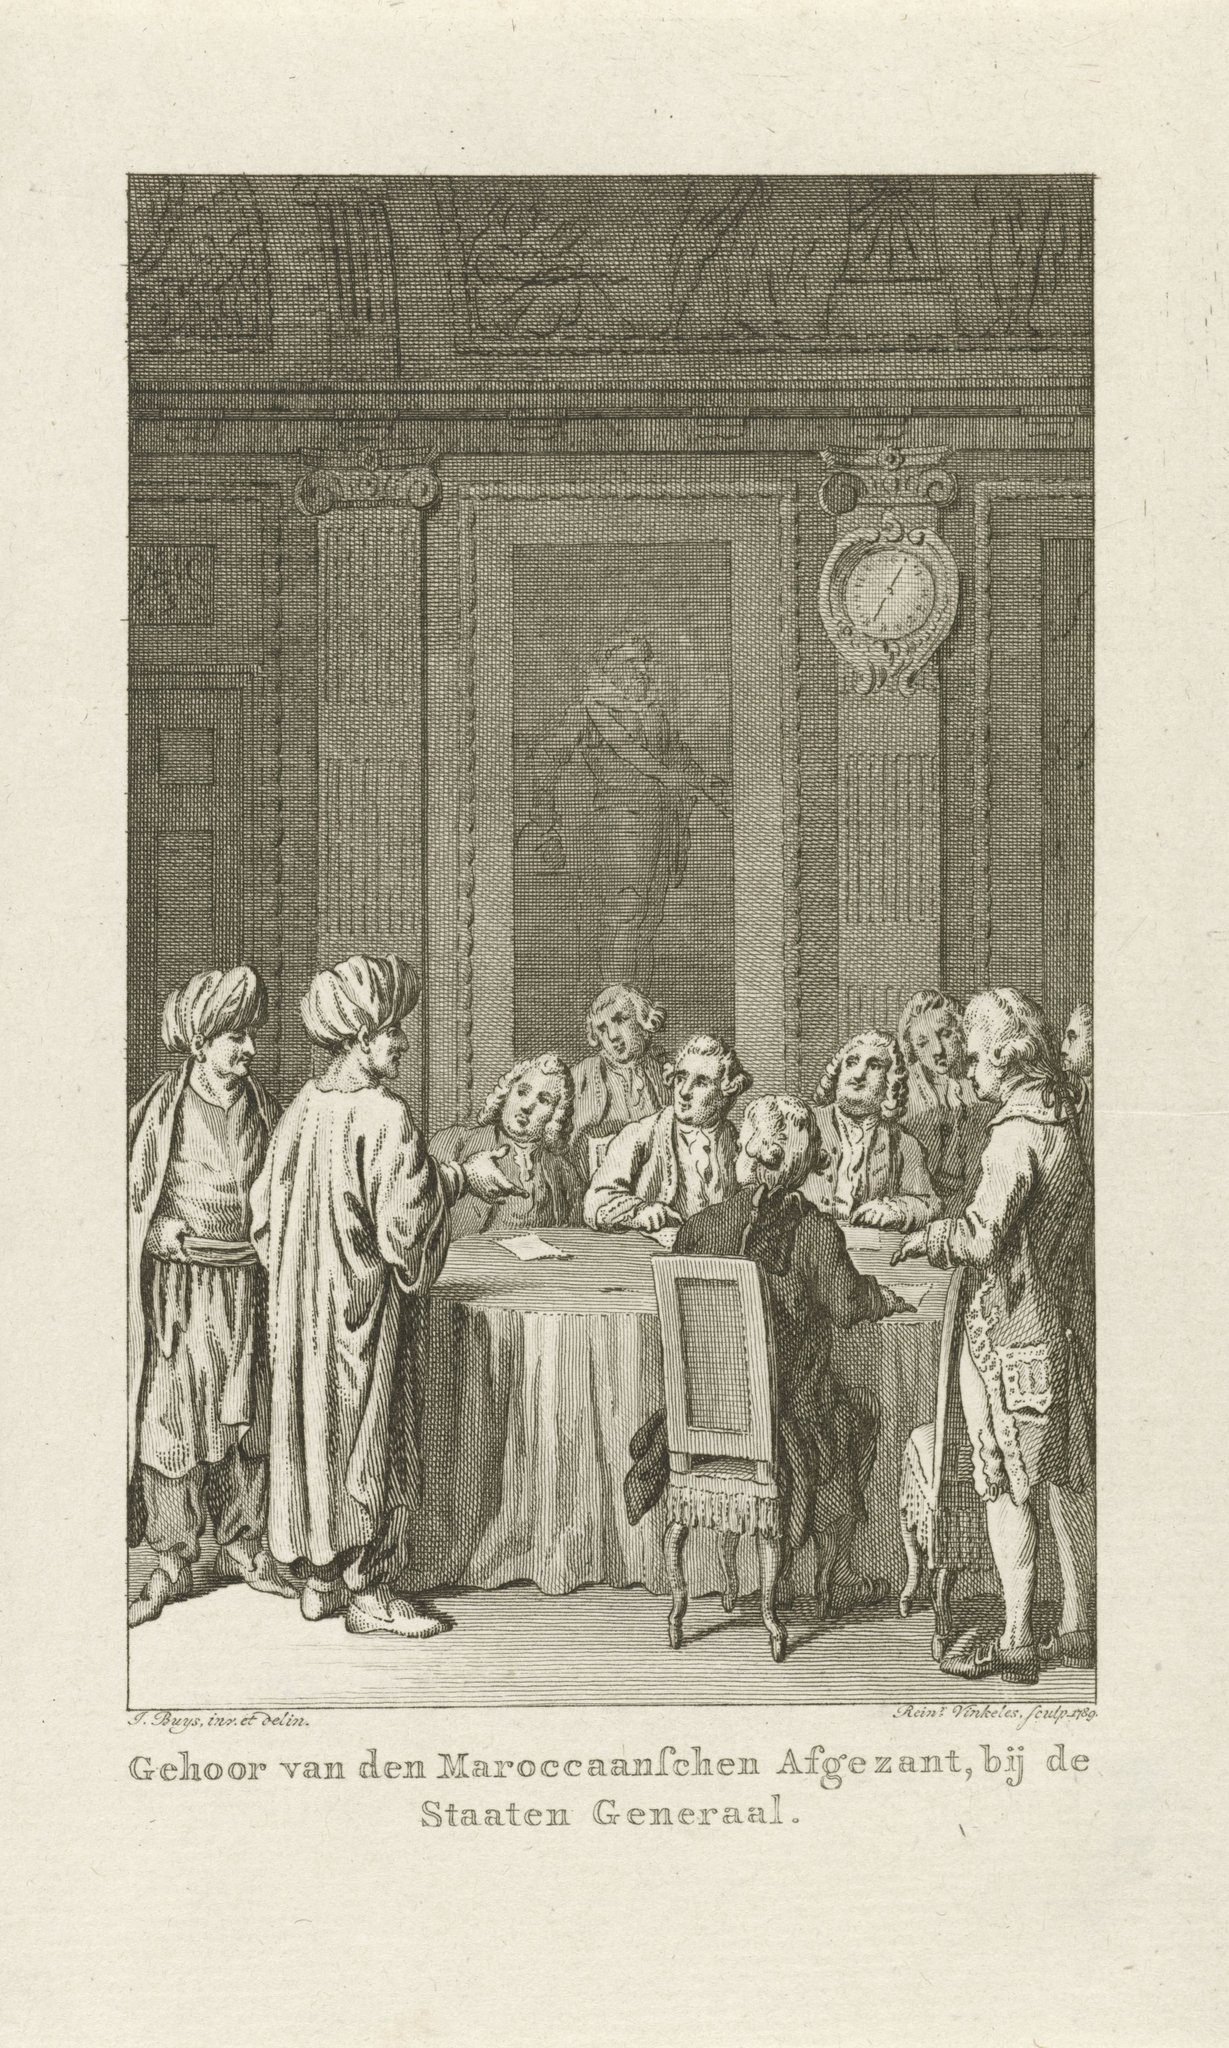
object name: history print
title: Marokkaanse afgezant op gehoor bij de Staten-Generaal, 1770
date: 1789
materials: paper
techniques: engraving, etching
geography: northern netherlands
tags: the hague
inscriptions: collector's mark: Lugt 2228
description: Huidige staat van prent ook gebruikt in: Loosjes, P.A. Vaderlandsche historie, vervattende de geschiedenissen der Vereenigde Nederlanden […] Ten vervolge van Wagenaars Vaderlandsche historie. 48 delen. Amsterdam: Johannes Allart, 1786-1811, dl. 24 (1789), tussen p. 190 en 191.